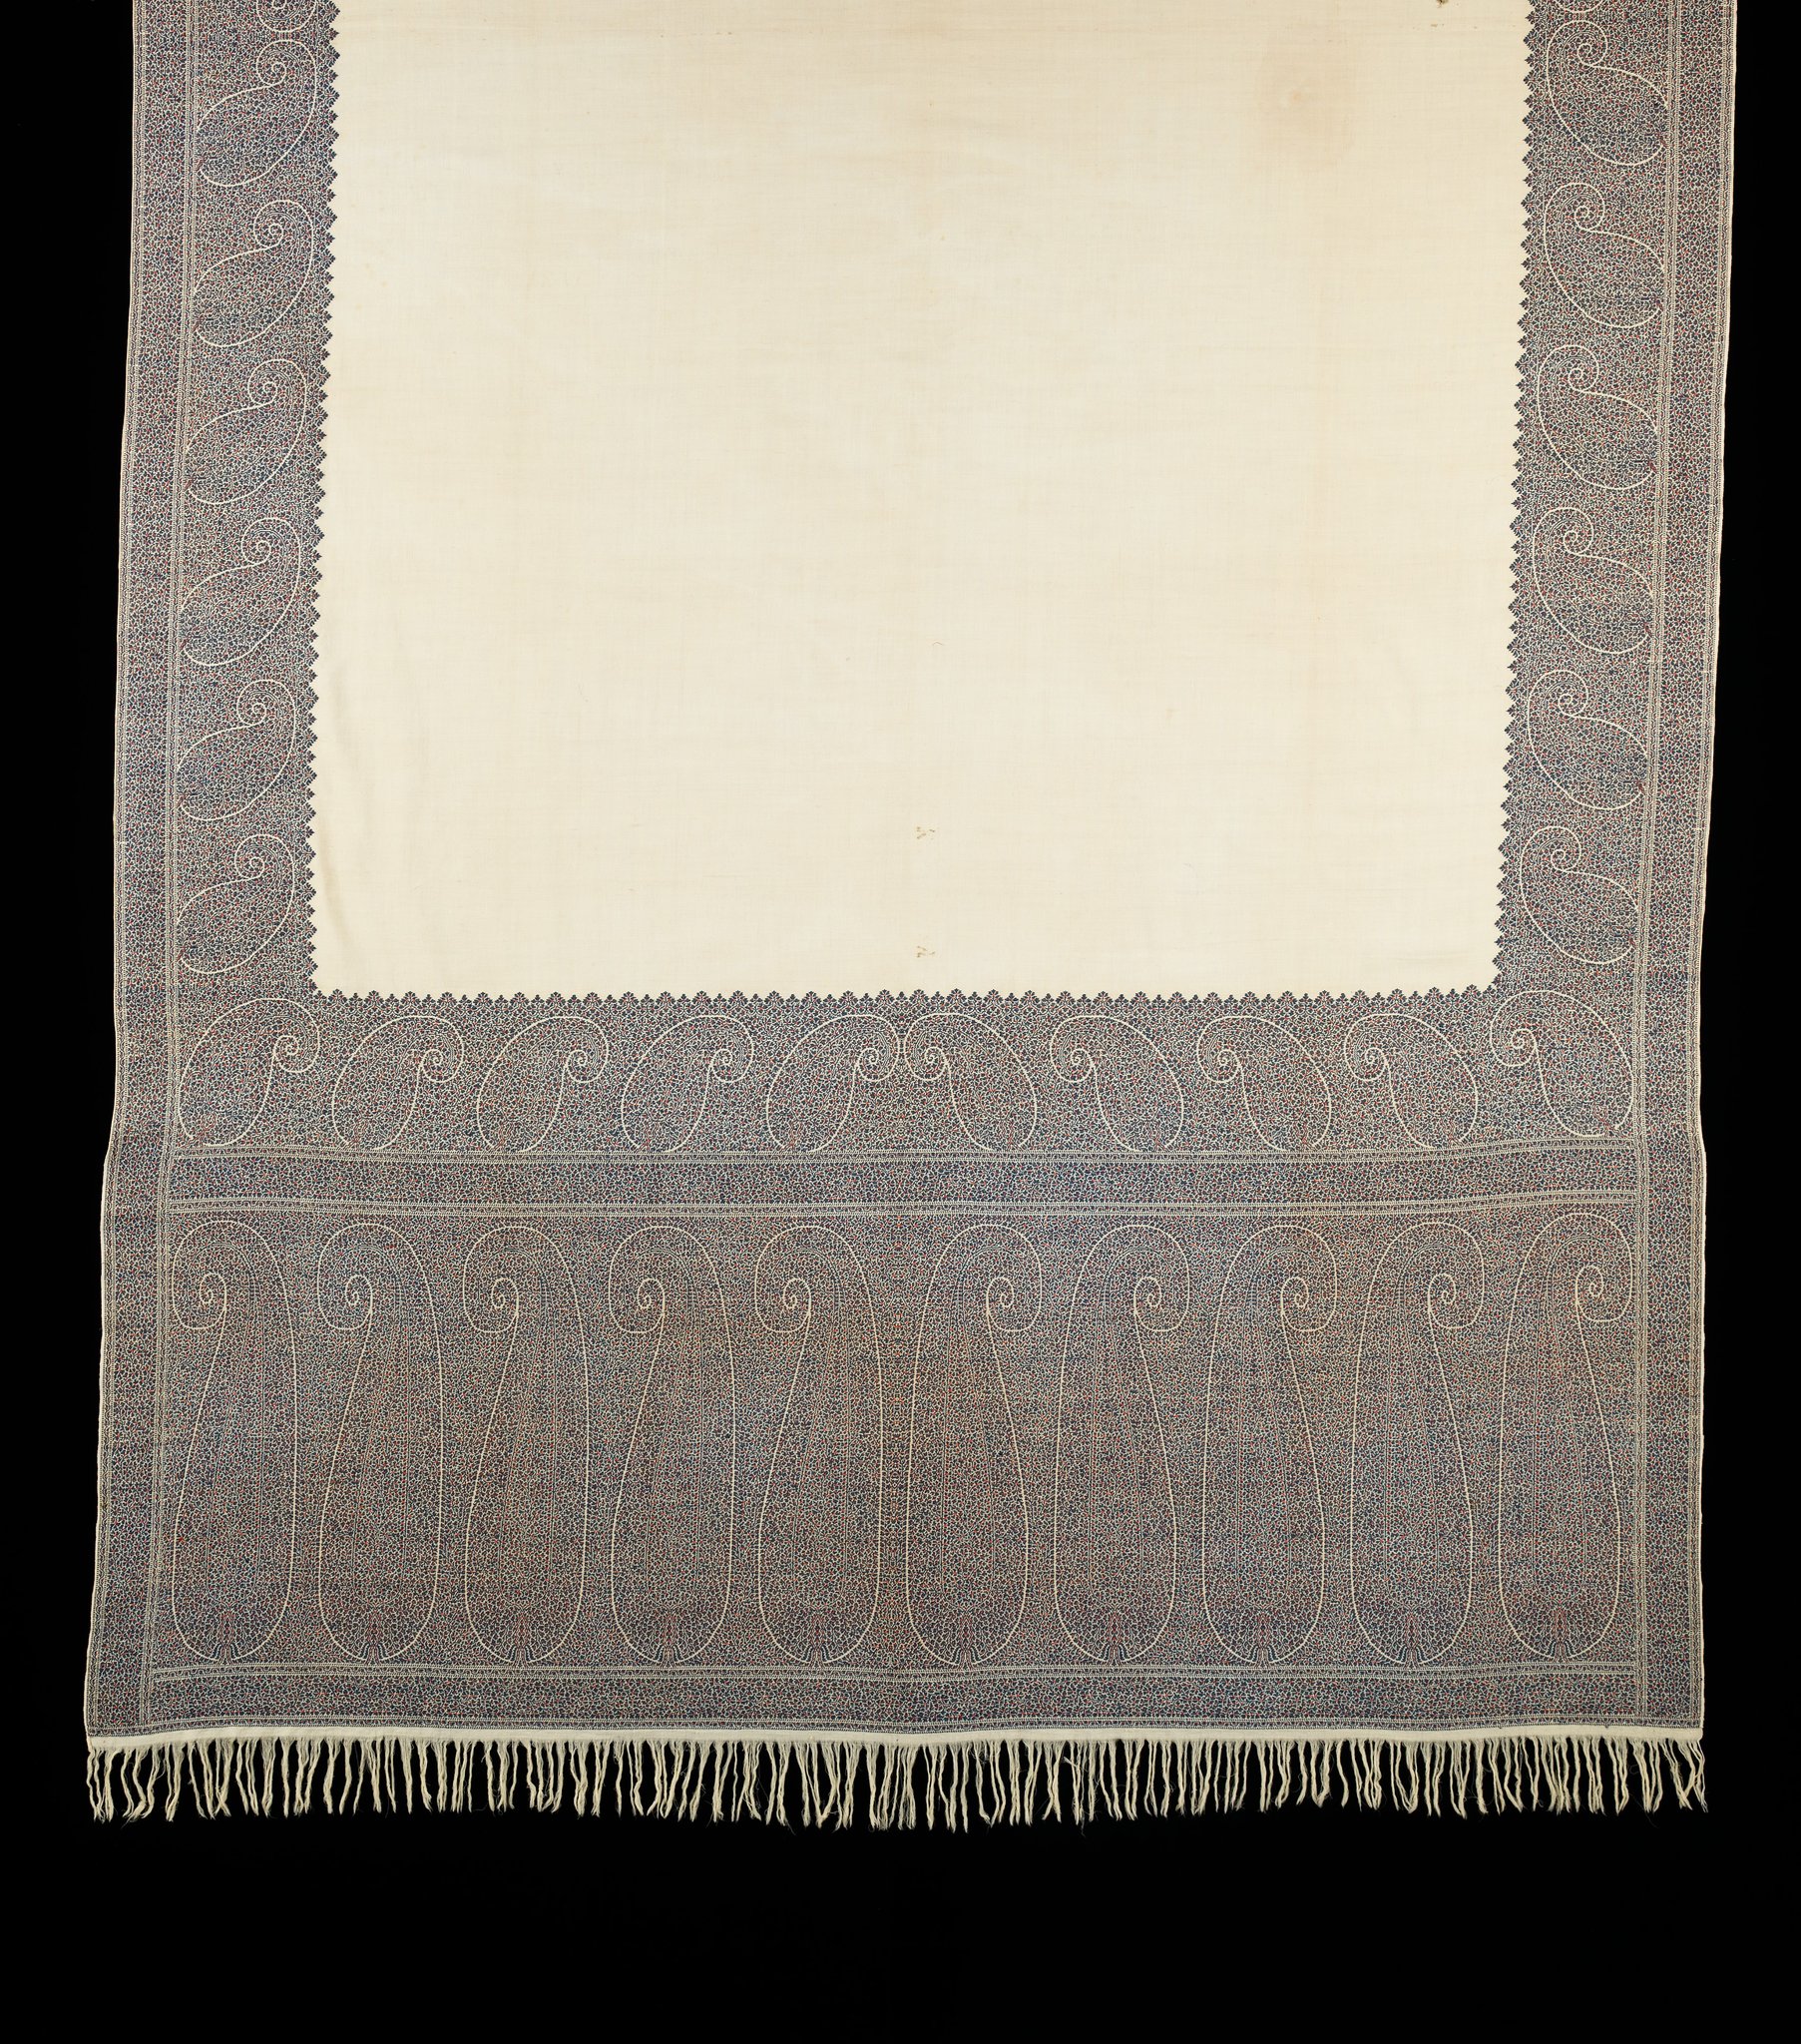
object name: shawl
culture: french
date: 1840-1849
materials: wool